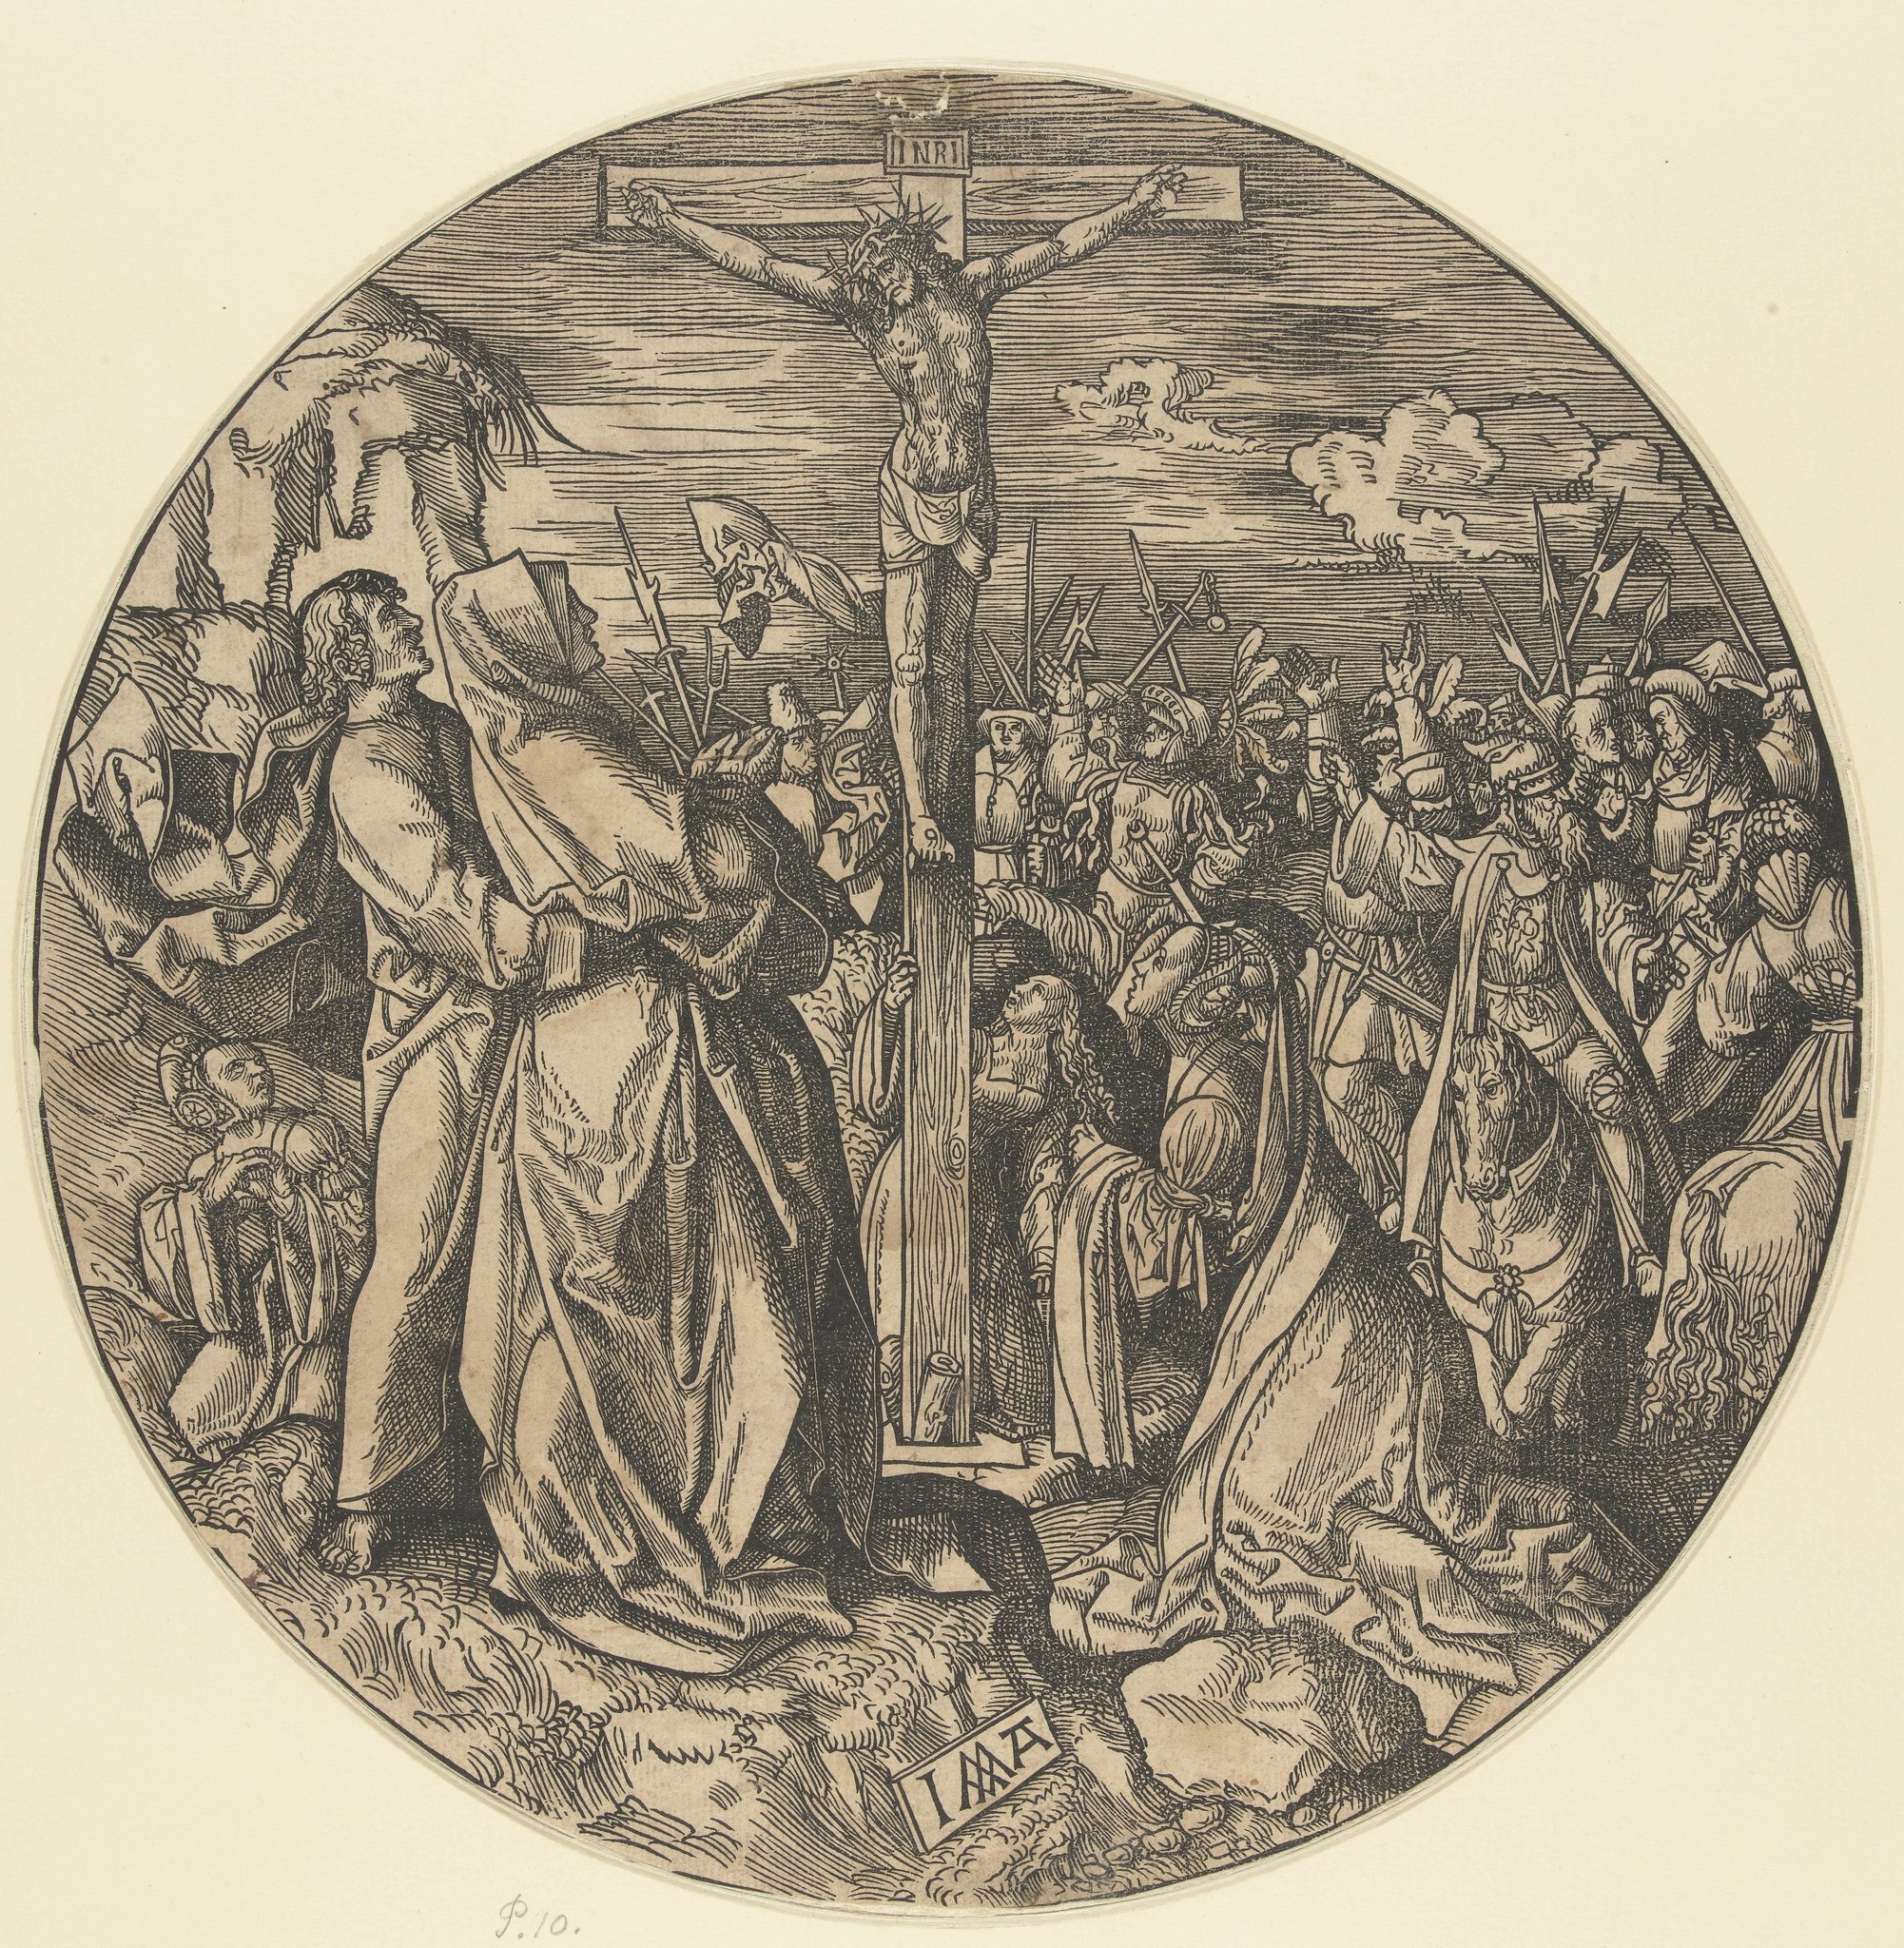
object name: print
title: De Ronde Passie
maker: jacob cornelisz van oostsanen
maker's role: draughtsman, painter, print maker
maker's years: 1475-1533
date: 1517-1533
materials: paper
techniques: woodcut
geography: low countries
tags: crucified christ, with particular persons under the cross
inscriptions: inscription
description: Uit serie van twaalf prenten, omlijsting weggesneden.